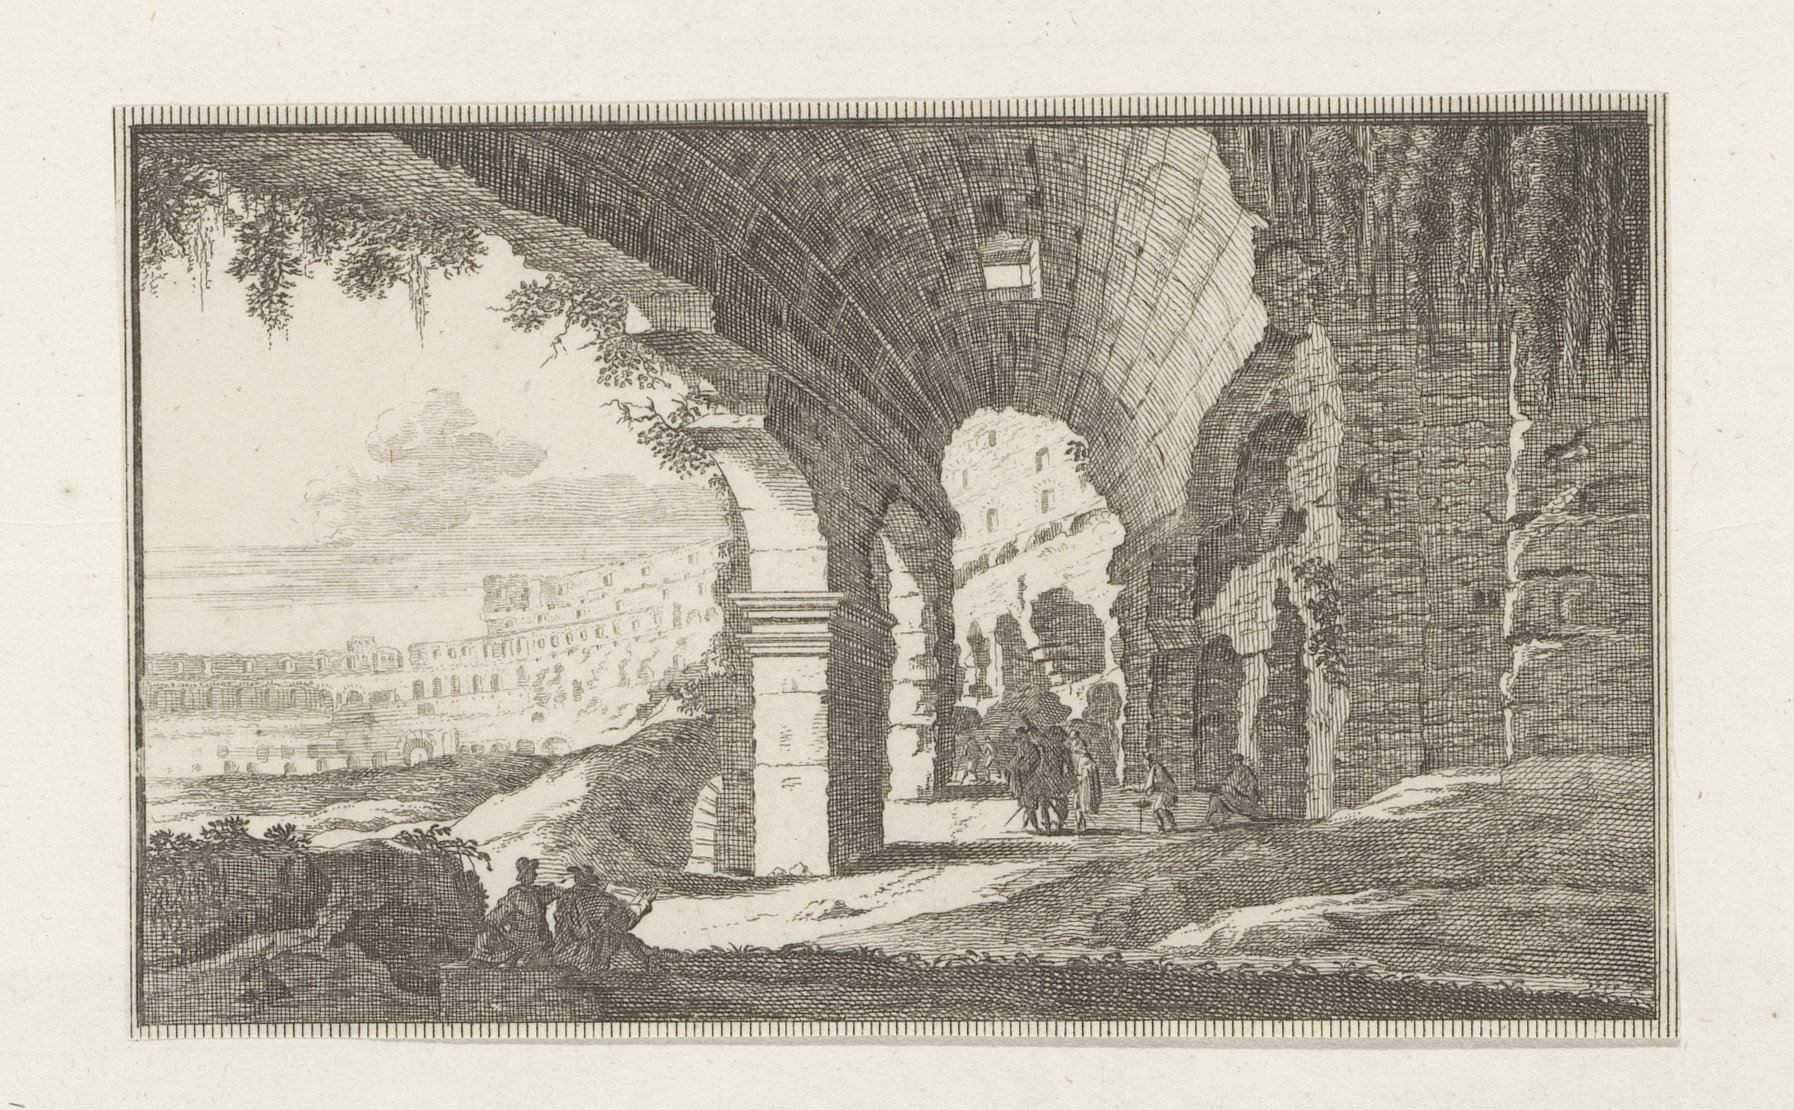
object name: album leaf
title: Colosseum te Rome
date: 1729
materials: paper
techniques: etching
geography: rome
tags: ruin of a building ~ architecture, theatre (building)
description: Deze voorstelling is geknipt uit een blad met twee prenten, met in totaal drie voorstellingen.